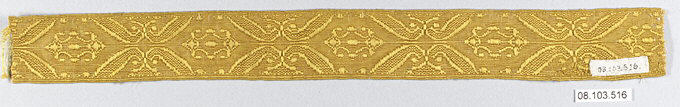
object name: galloon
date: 1701-1800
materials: cotton, silk